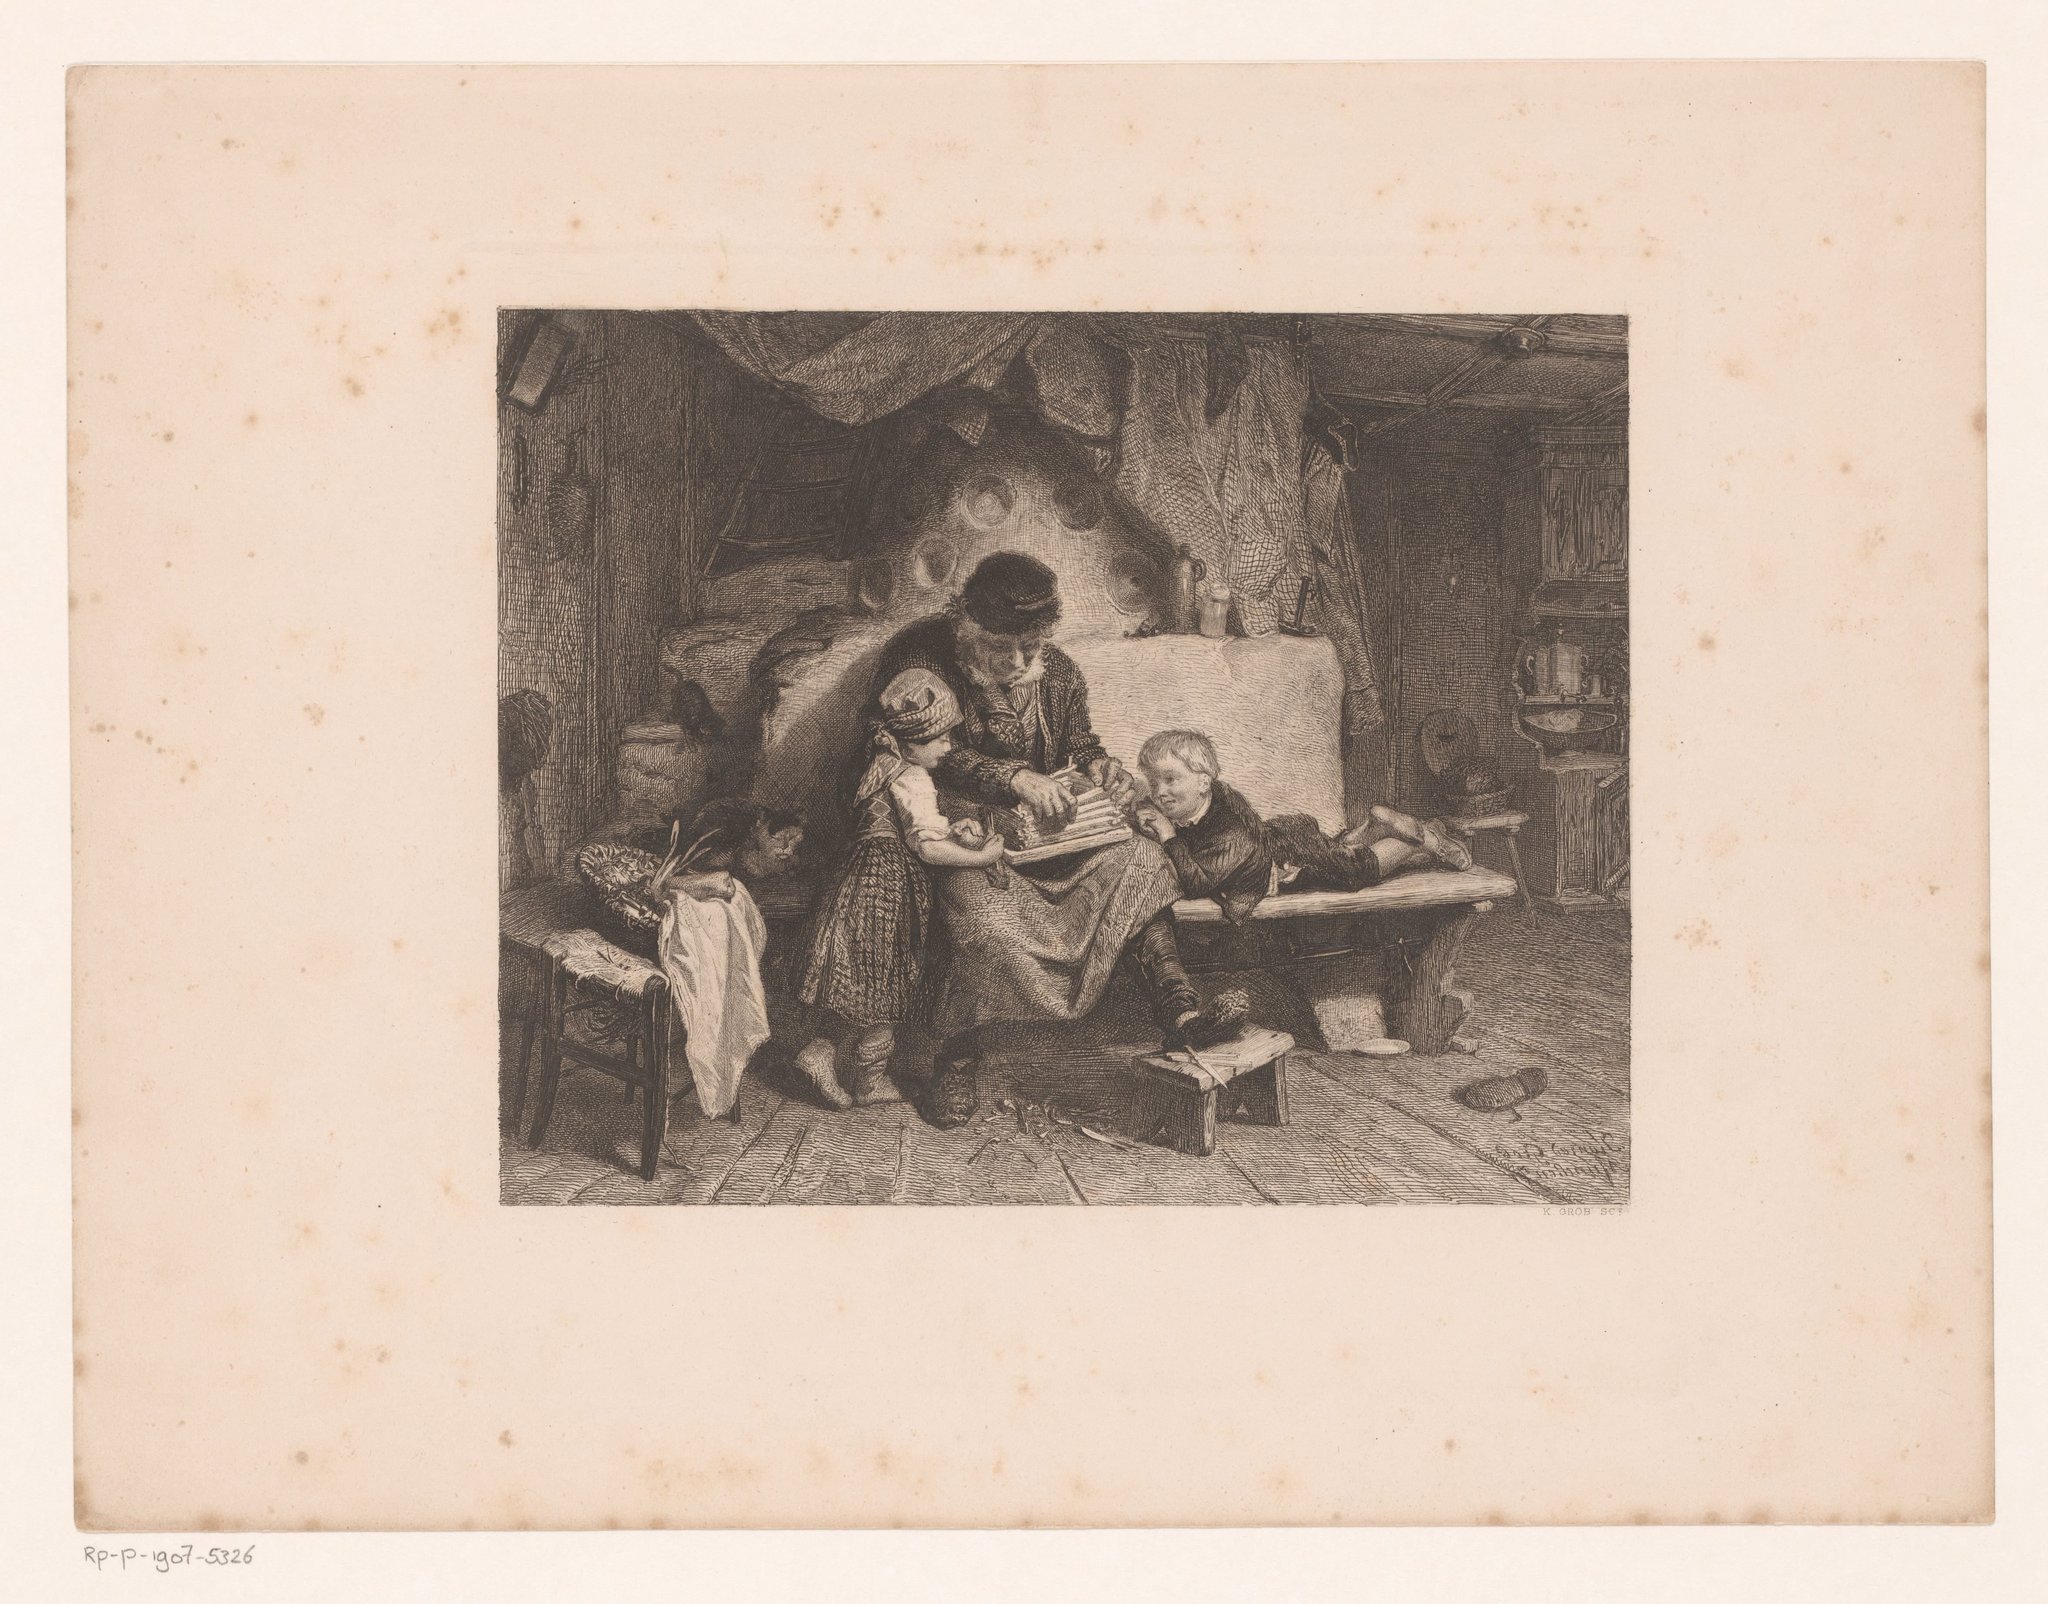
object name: print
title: Twee kinderen kijken hoe een oude man een houten vogelkooi maakt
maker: konrad grob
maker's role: print maker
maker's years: 1828-1904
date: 1838-1904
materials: paper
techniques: etching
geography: munich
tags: cat, child, old man, interior of the house, handicrafts ~ wood, timber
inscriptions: collector's mark: Lugt 2228